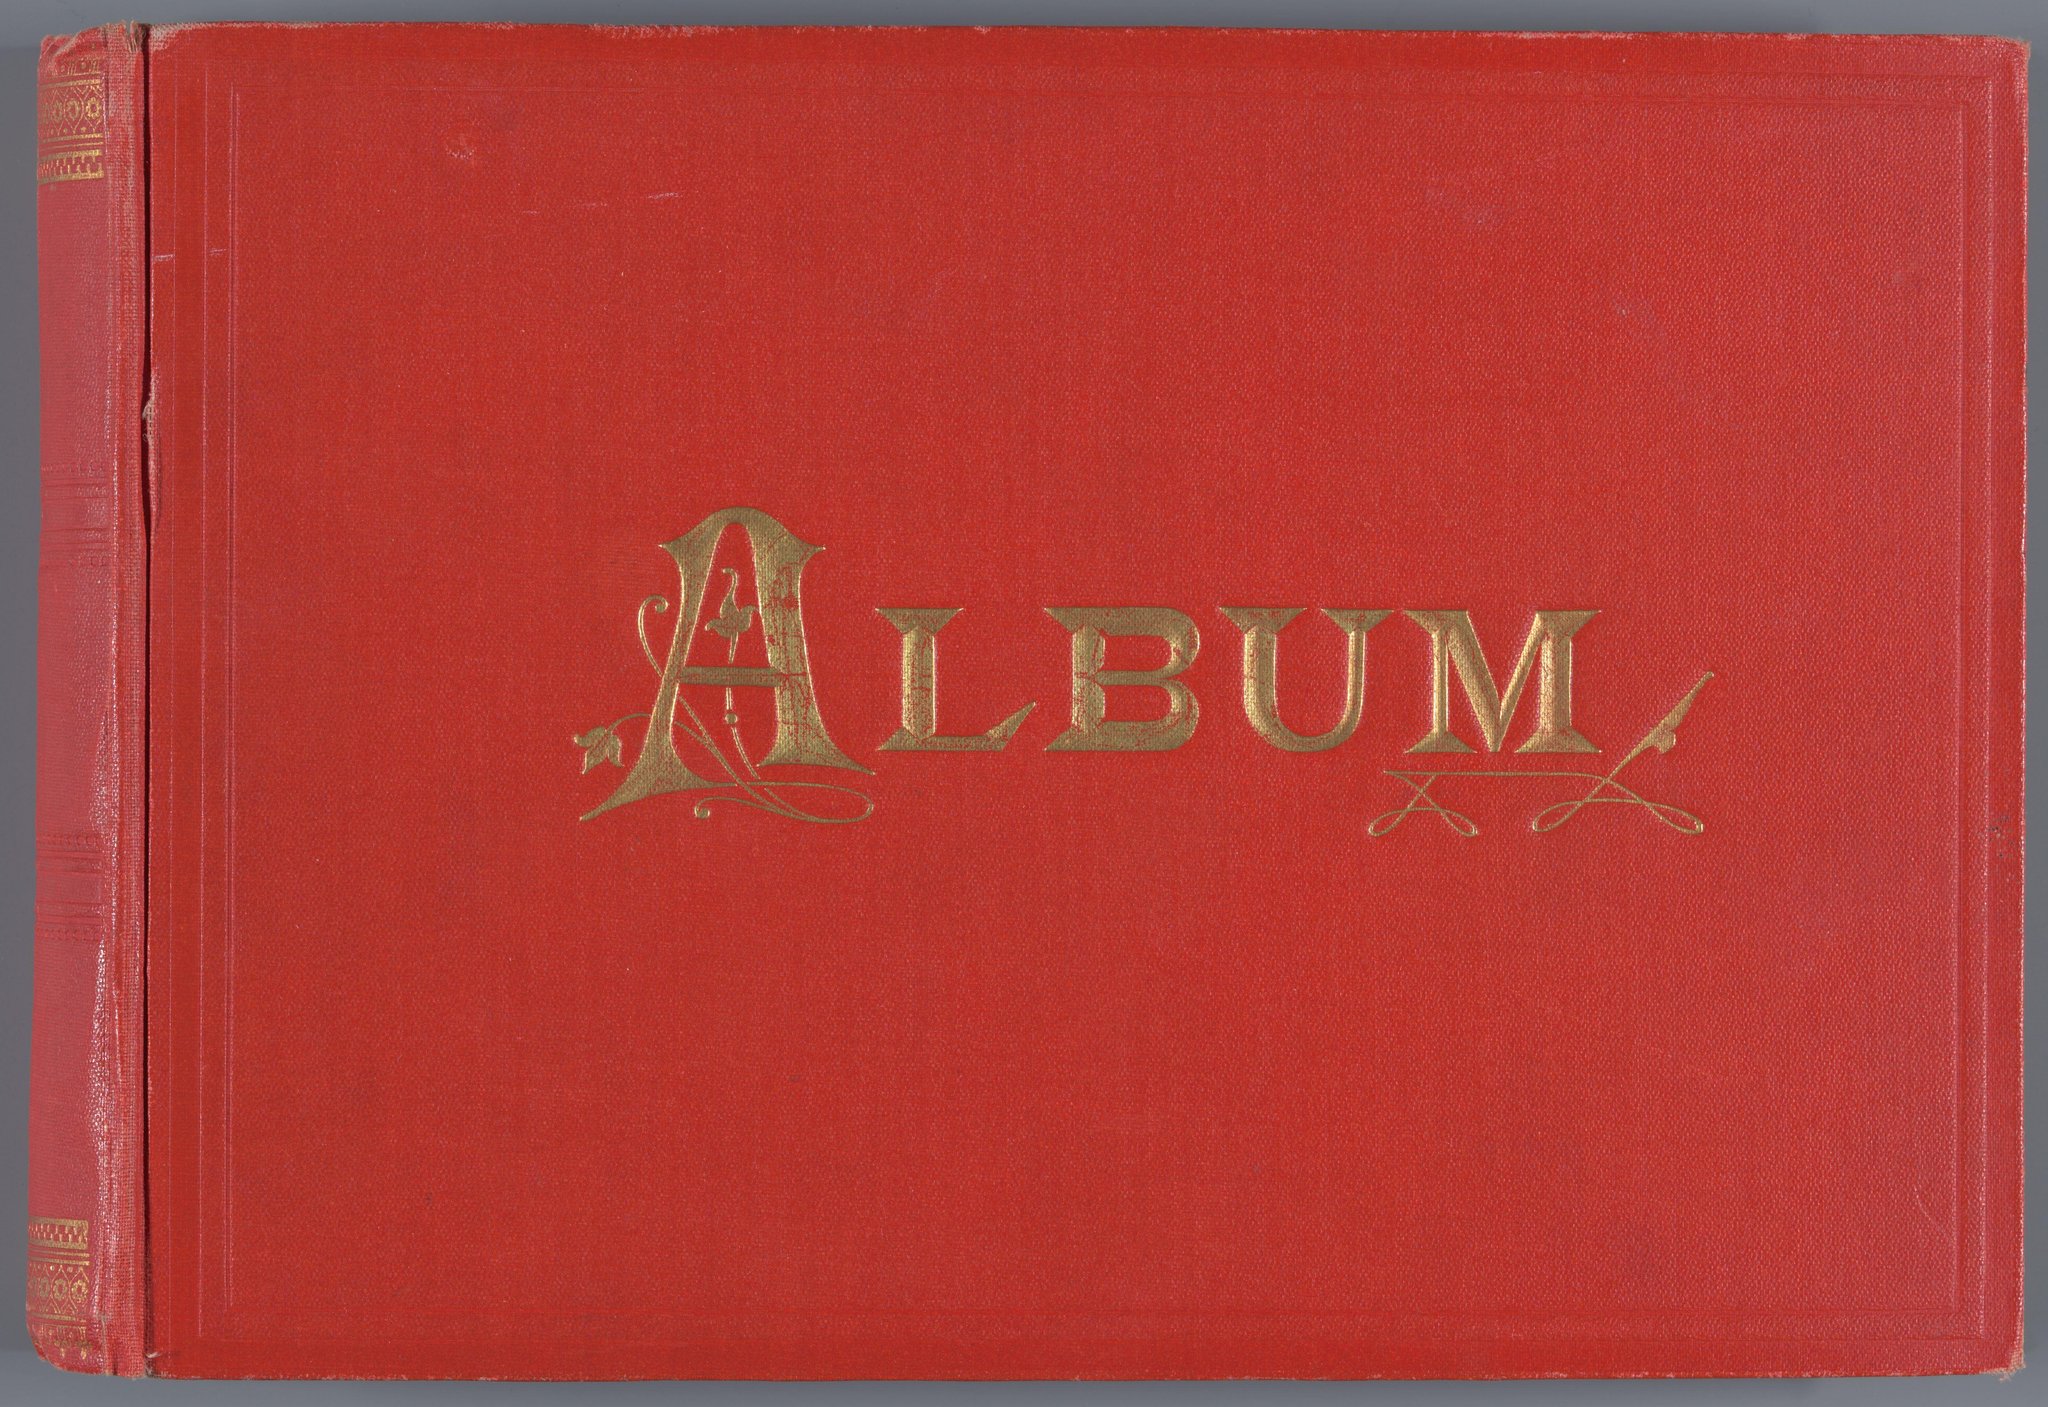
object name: photograph album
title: Fotoalbum Gerard Aalbersberg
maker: gerard aalbersberg (us)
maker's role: amateurfotograaf, arts, chirurg, gynaecoloog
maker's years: 1870-1934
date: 1887-1906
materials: paper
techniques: photography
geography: netherlands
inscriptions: inscription: ‘f. 2,10’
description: Fotoalbum in rode linnen band met op het voorplat de titel 'Album' in sierlijke gouden letters gedrukt. Het album bevat 37 foto's op 32 kartonnen bladen. Achterin zijn ongebruikte bladen. De arts en amateurfotograaf Gerard Aalbersberg (1870-1934) stelde het album samen. Het bevat een gezicht op Oudezijds Achterburgwal, landschappen op de Veluwe bij Nunspeet, groepjes, volkstypen (Hendrikje, de bruûr van 't lijk) en een fotoverhaal geënsceneerd door vrienden in een Amsterdams park. Er zijn foto's van vriendengroepjes waaronder de kunstenaar Jan Kleintjes (1867-1938) en zijn vrouw Hedwig in een huis met onder andere Japanse prenten en er zijn foto's gemaakt op tennispark De Bataaf in Den Haag. Namen die verder voorkomen zijn W.Wybrants, G.Gaaymans, Stien en Suze. Ook huisdieren Tom en Fritsje zijn gefotografeerd.